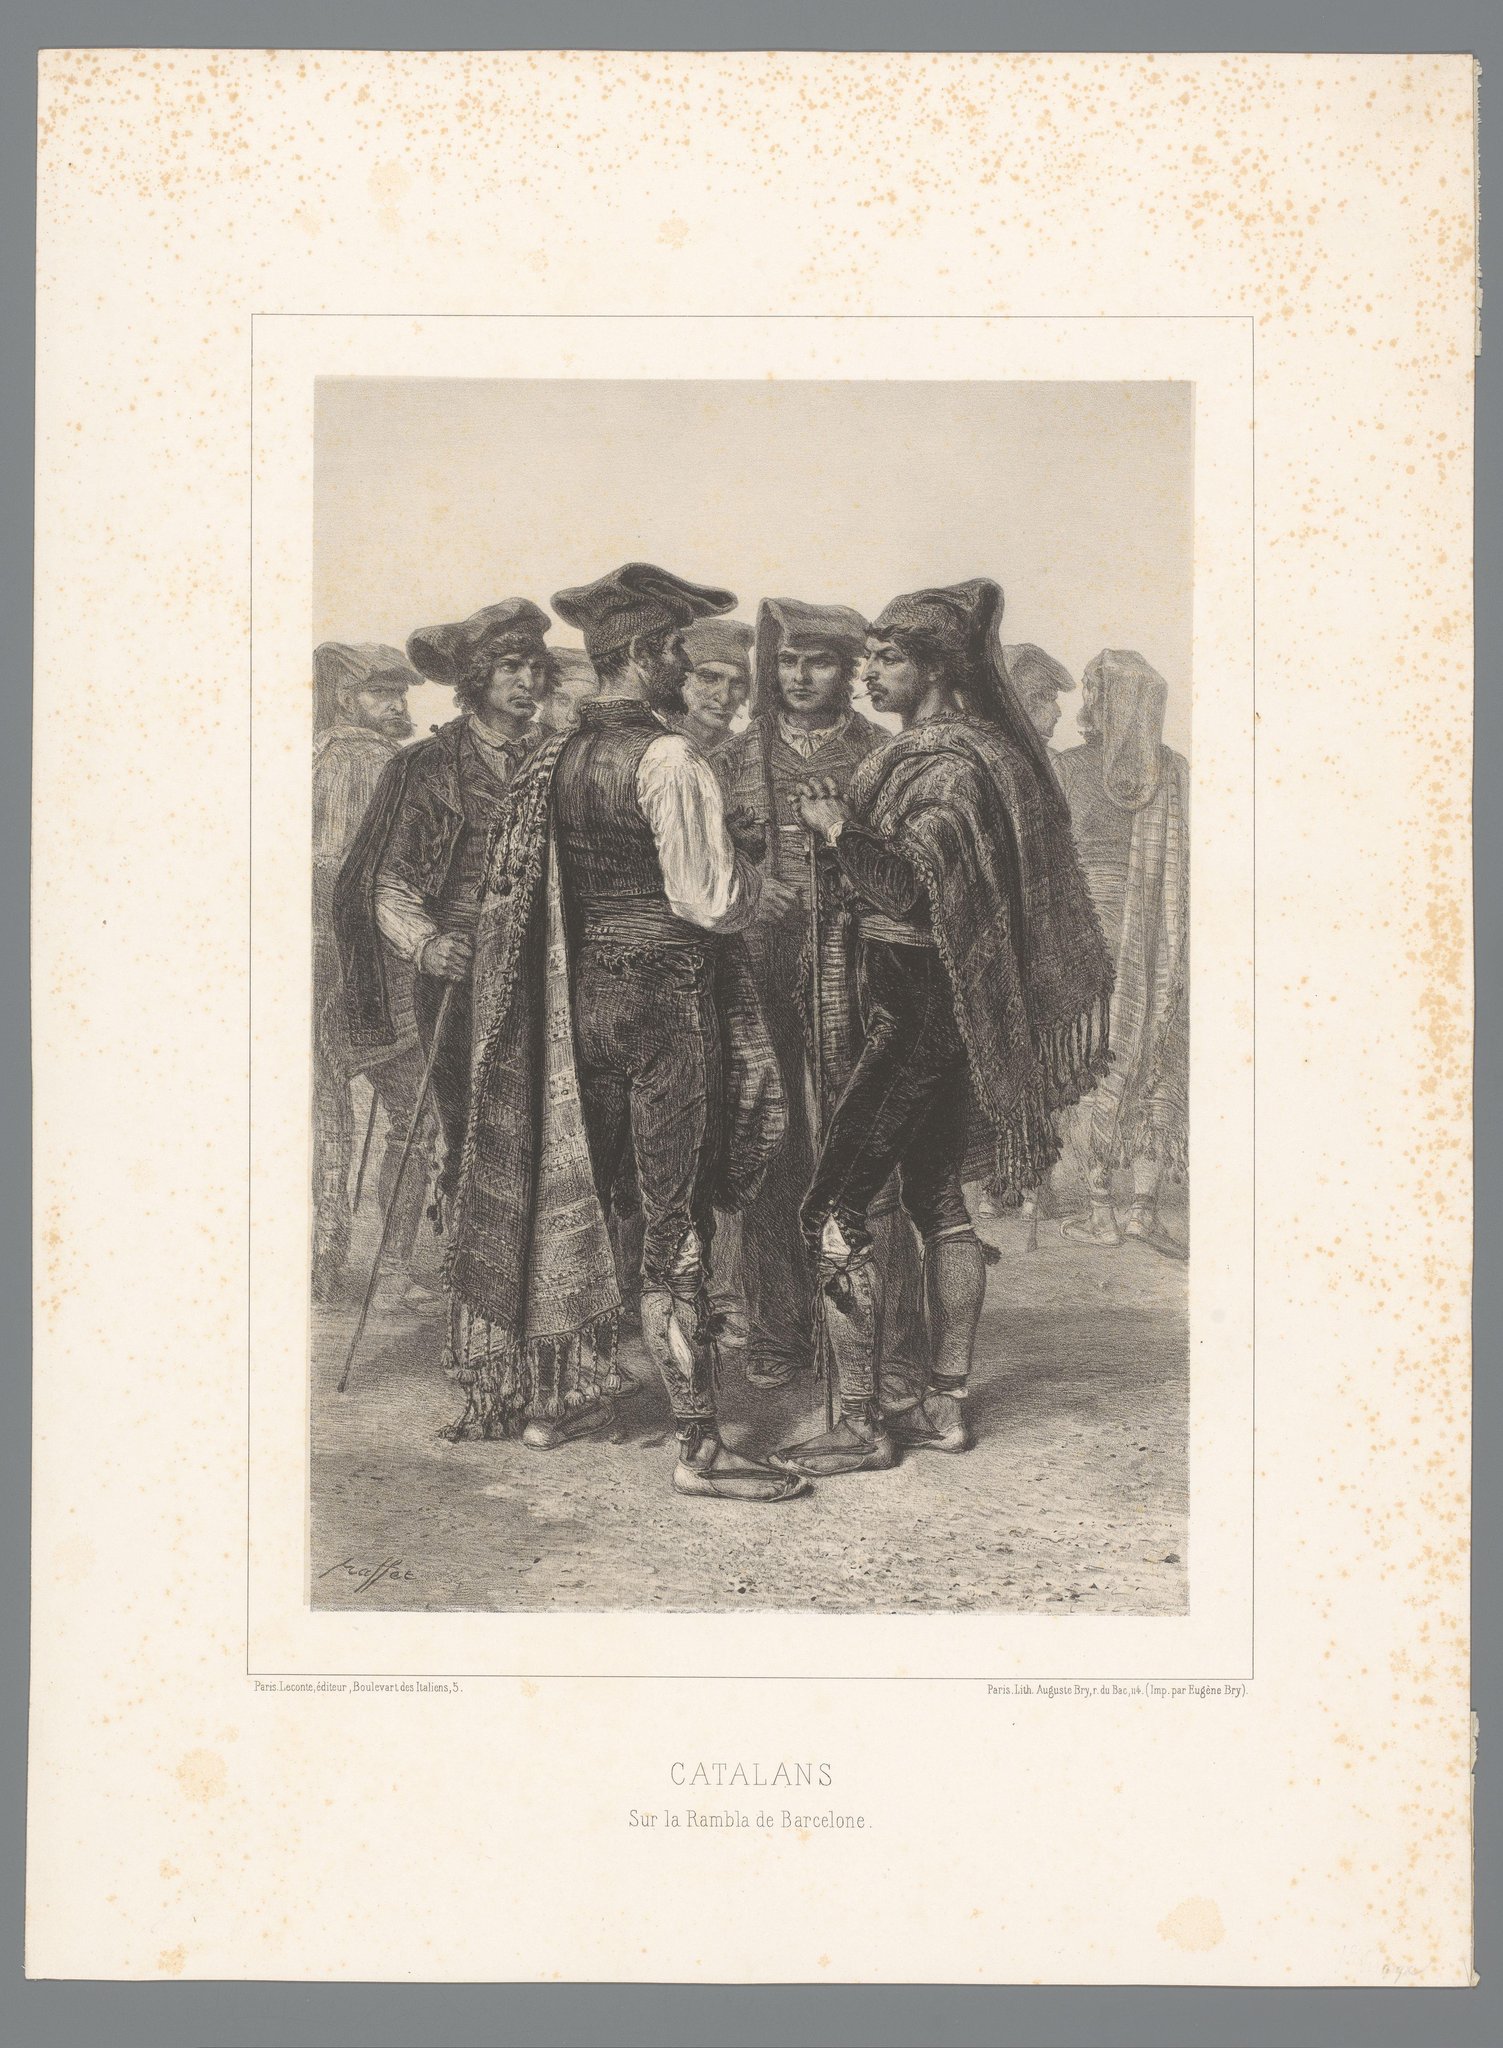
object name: print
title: Staande Catalaanse mannen op de Ramblas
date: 1854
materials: paper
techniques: lithograph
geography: paris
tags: cigarette, walking-stick, staff, adult man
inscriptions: collector's mark: Lugt 964